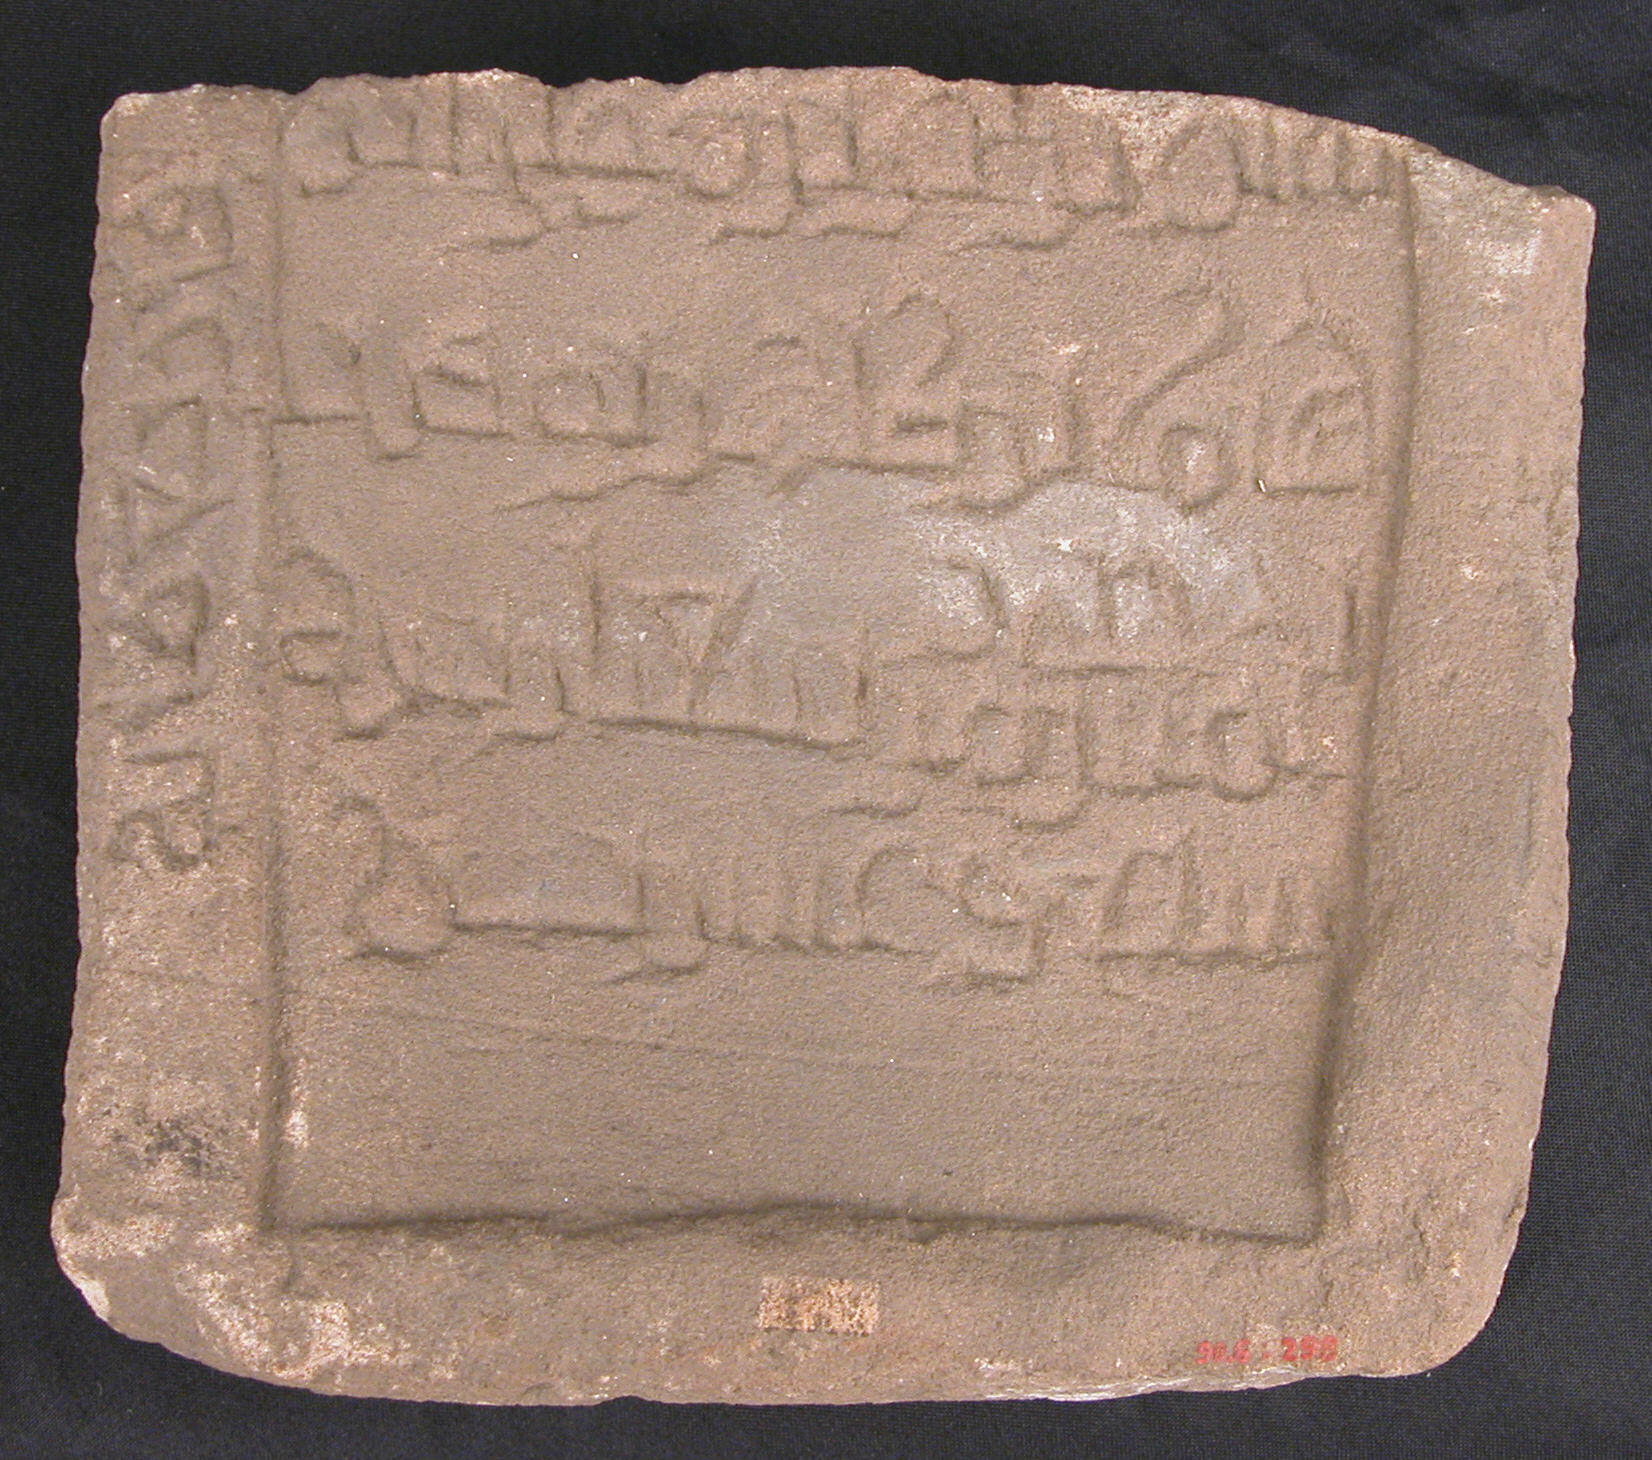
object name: tombstone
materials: stone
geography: egypt